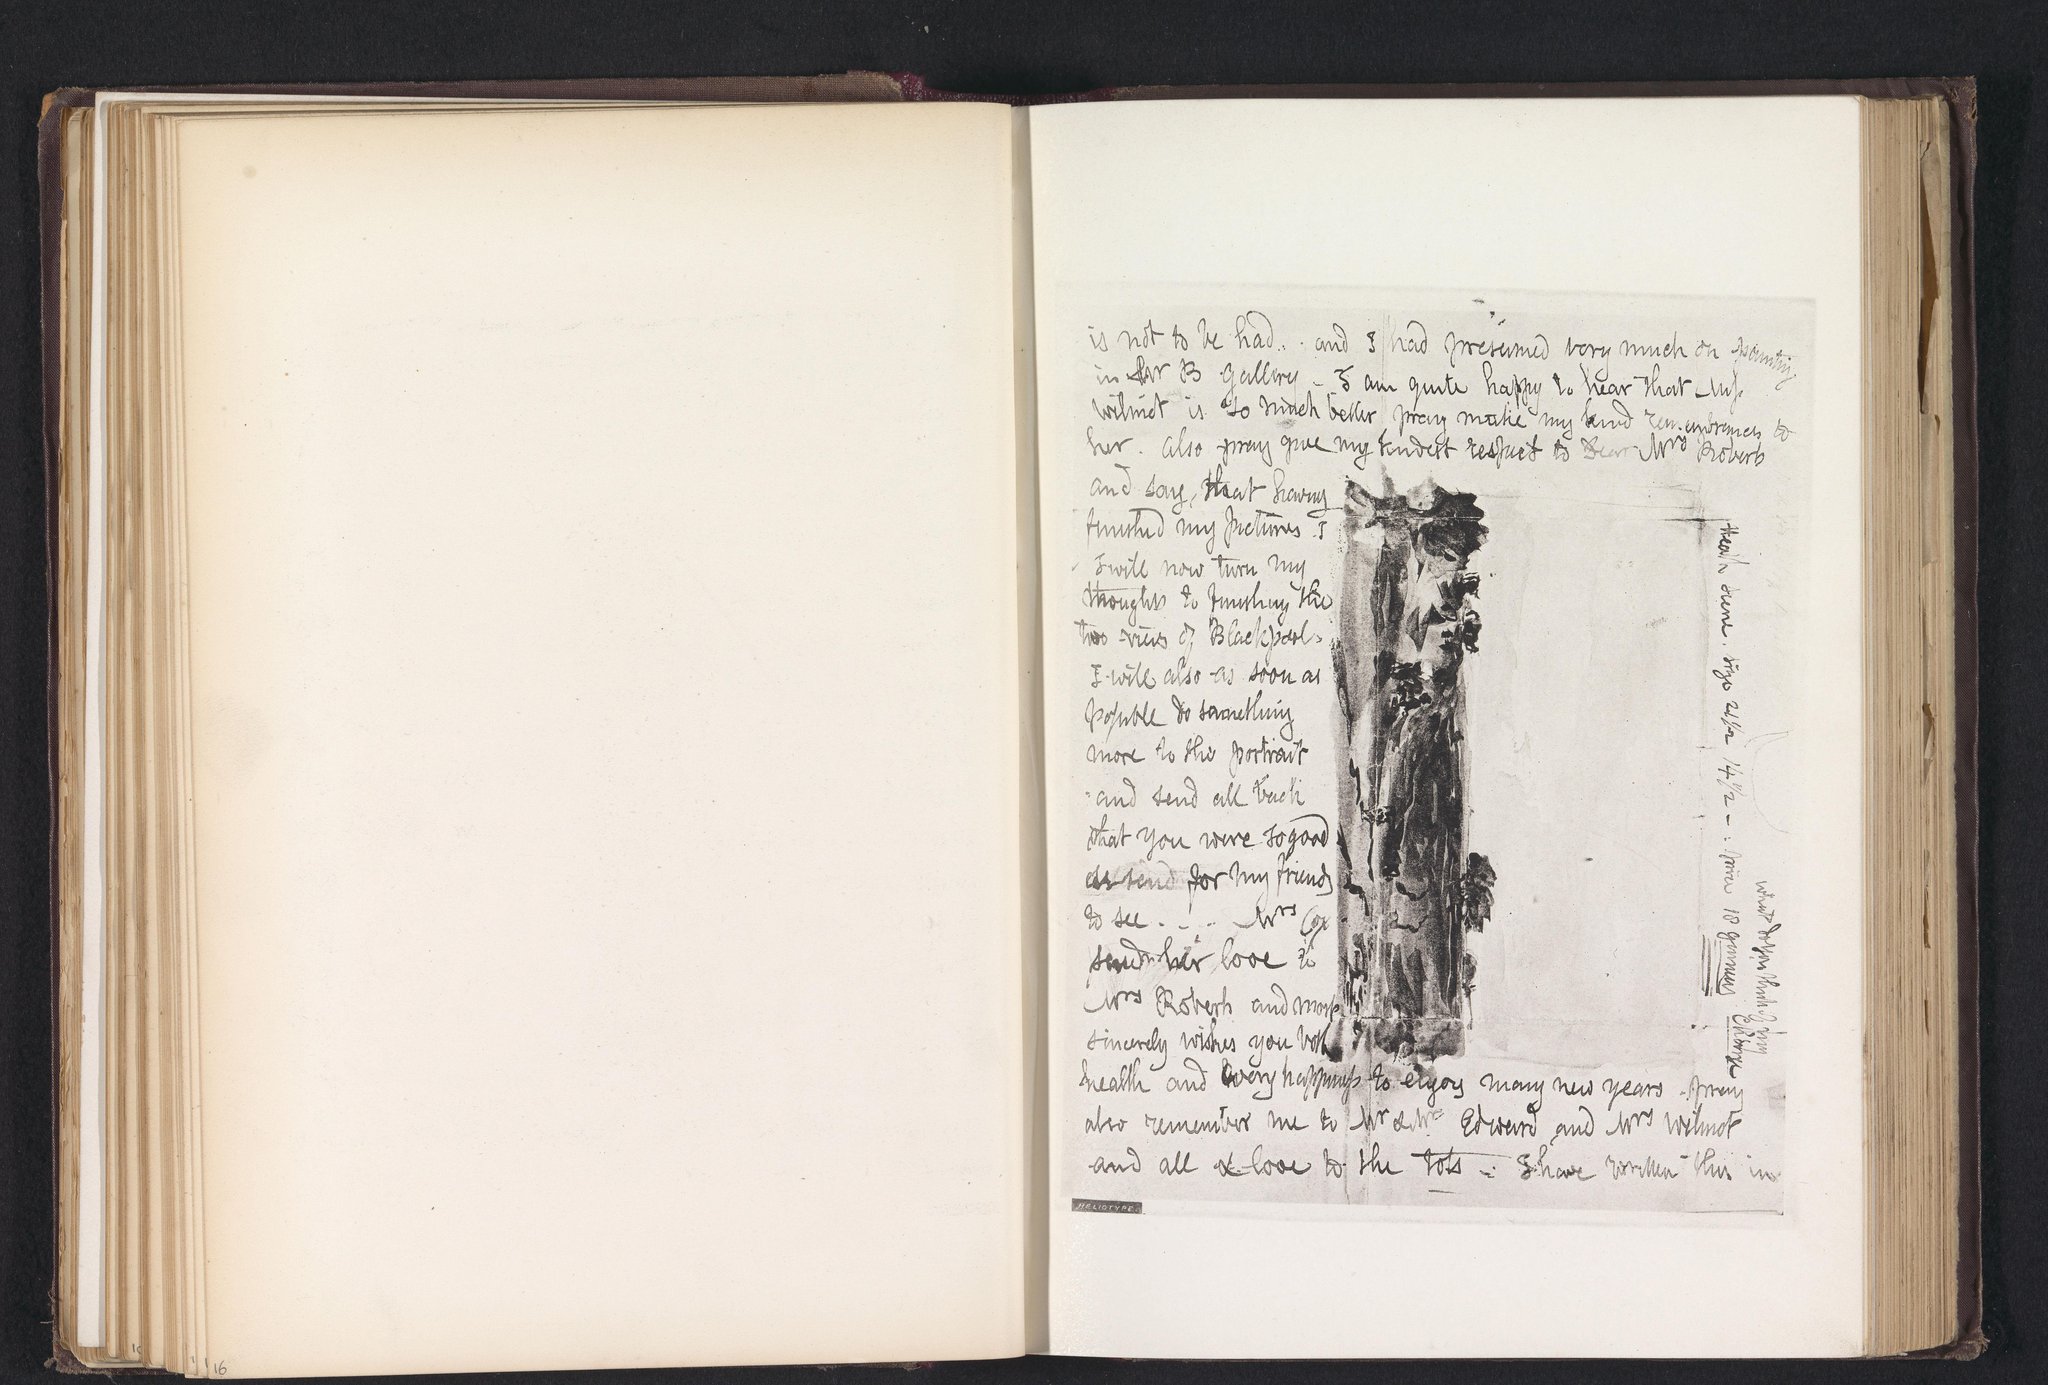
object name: photomechanical print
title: Fotoreproductie van een brief met een schets van een landschap van David Cox aan William Roberts op 12 januari van 1841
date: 1863-1873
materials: paper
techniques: photoaquatint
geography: london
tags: drawing, sketch, letter, envelope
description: RP-F-2001-7-66-15 tot en met RP-F-2001-7-66-18 vormen vermoedelijk samen een brief.